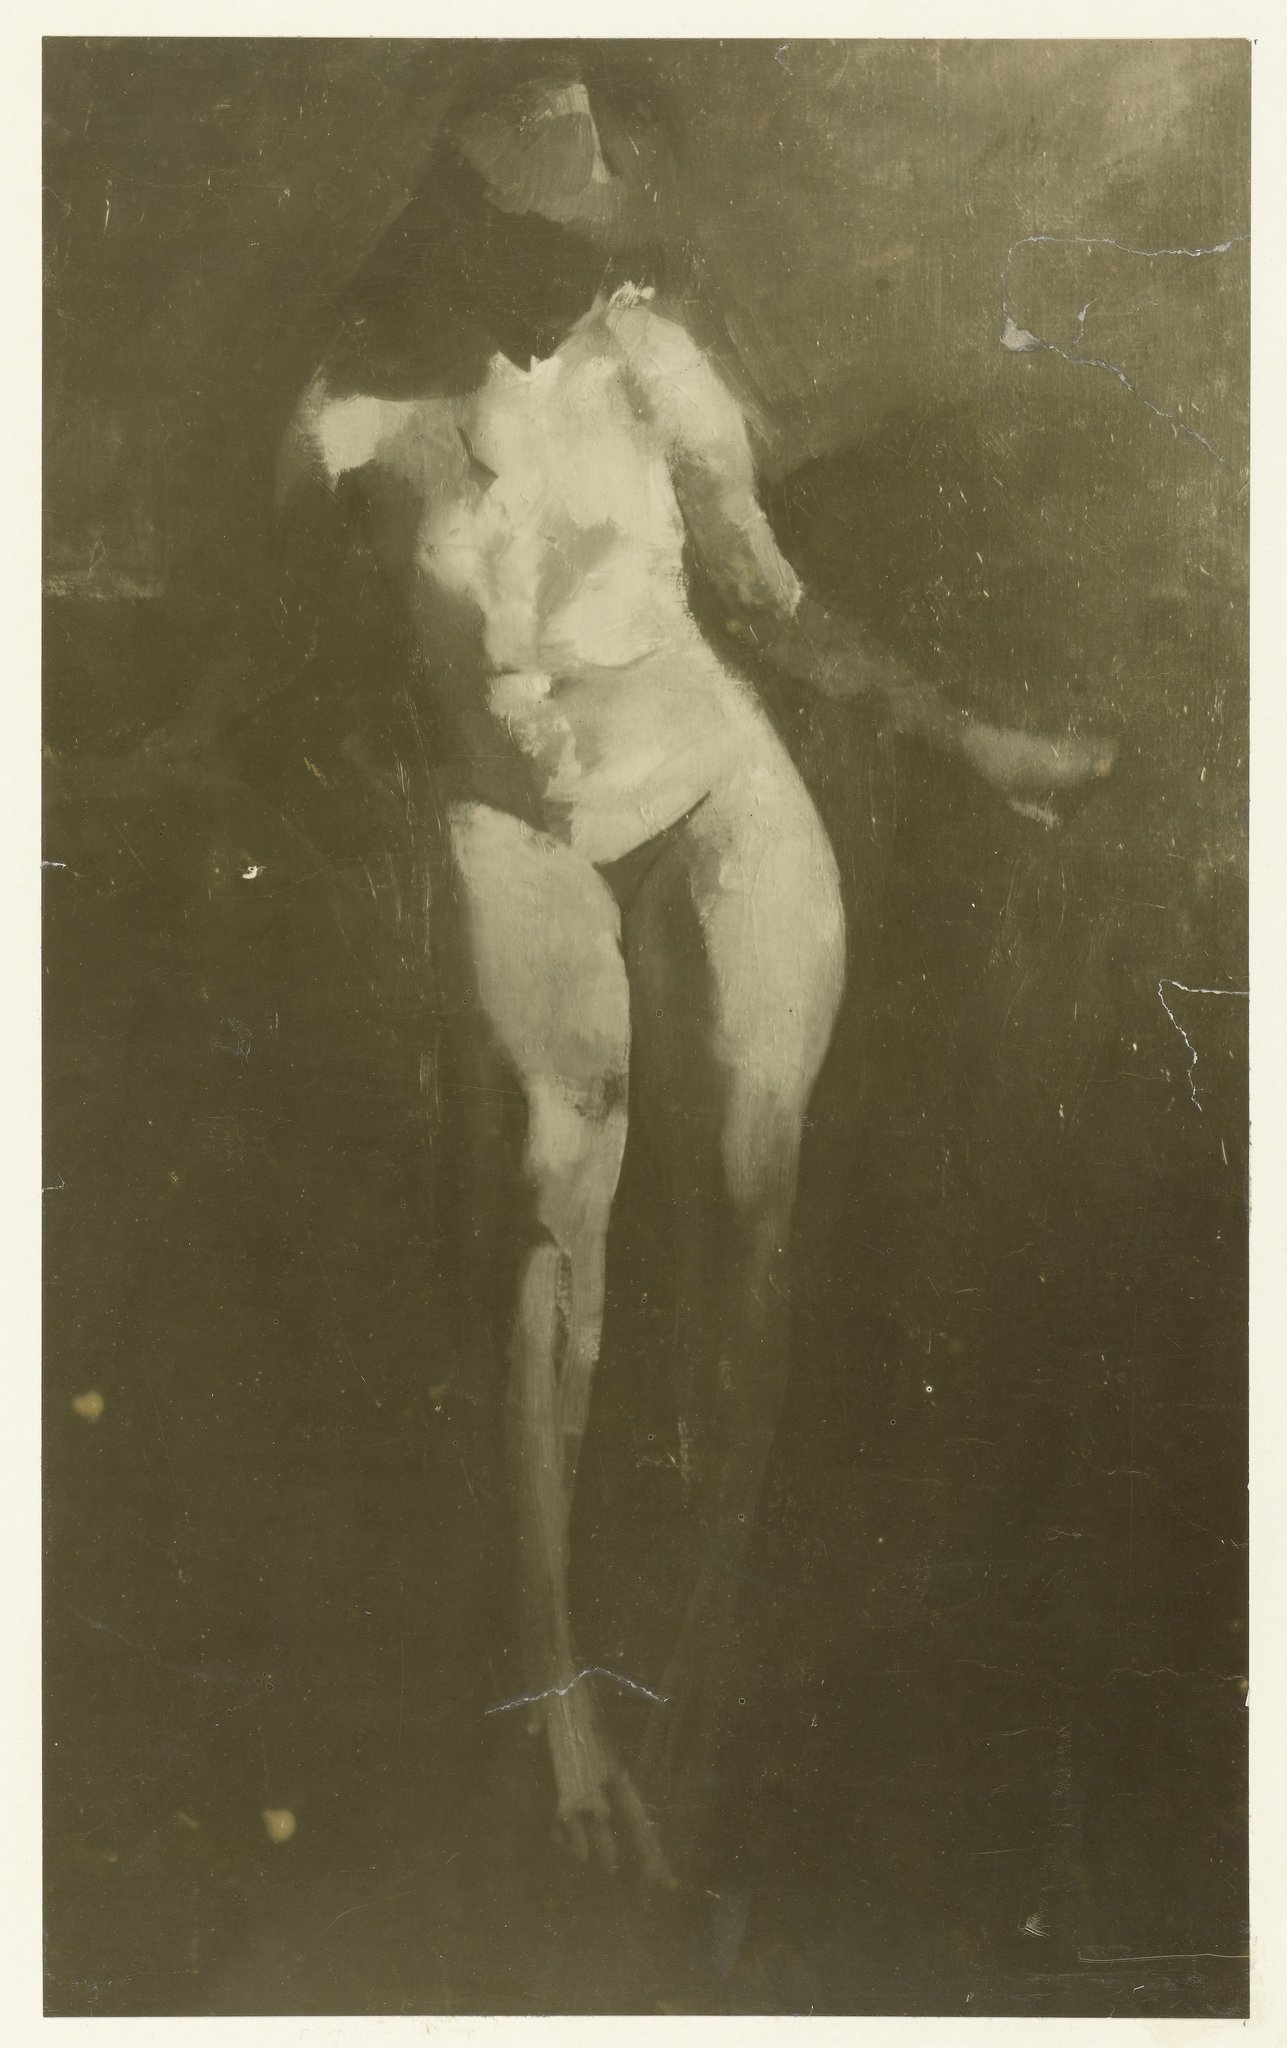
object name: photograph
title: Fotoreproductie van een schilderij van een staand vrouwelijk naakt door George Hendrik Breitner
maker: george hendrik breitner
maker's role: draughtsman, painter, print maker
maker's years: 1857-1923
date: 1886-1910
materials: paper, cardboard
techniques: gelatin silver print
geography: amsterdam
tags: woman (showing herself) undressed, quasi-nude, standing figure - aa - female human figure, picture, painting